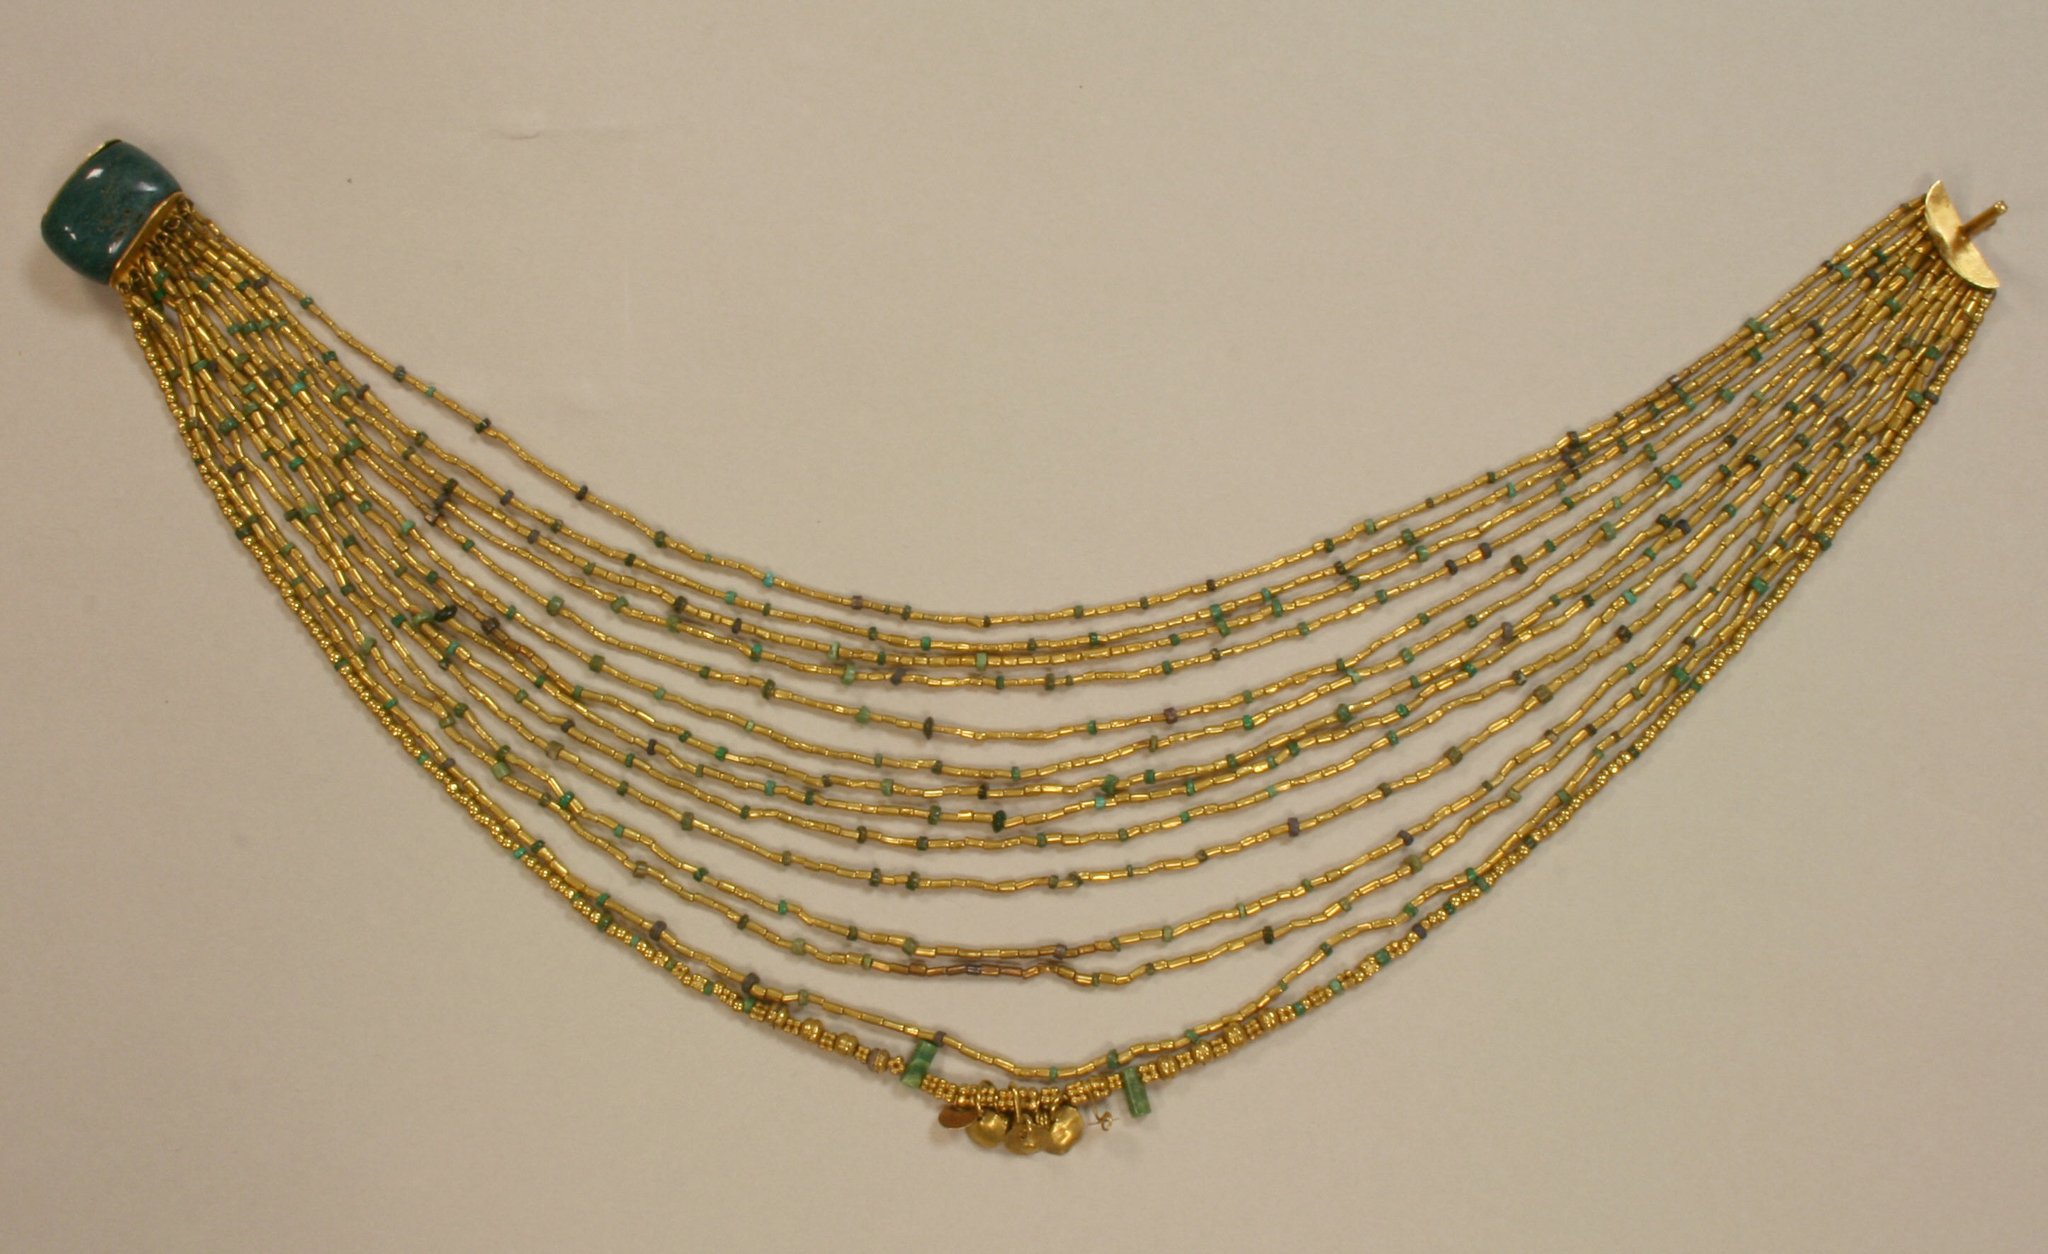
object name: necklace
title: Multi-strand Necklace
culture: calima or yotoco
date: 1-700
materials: gold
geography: colombia